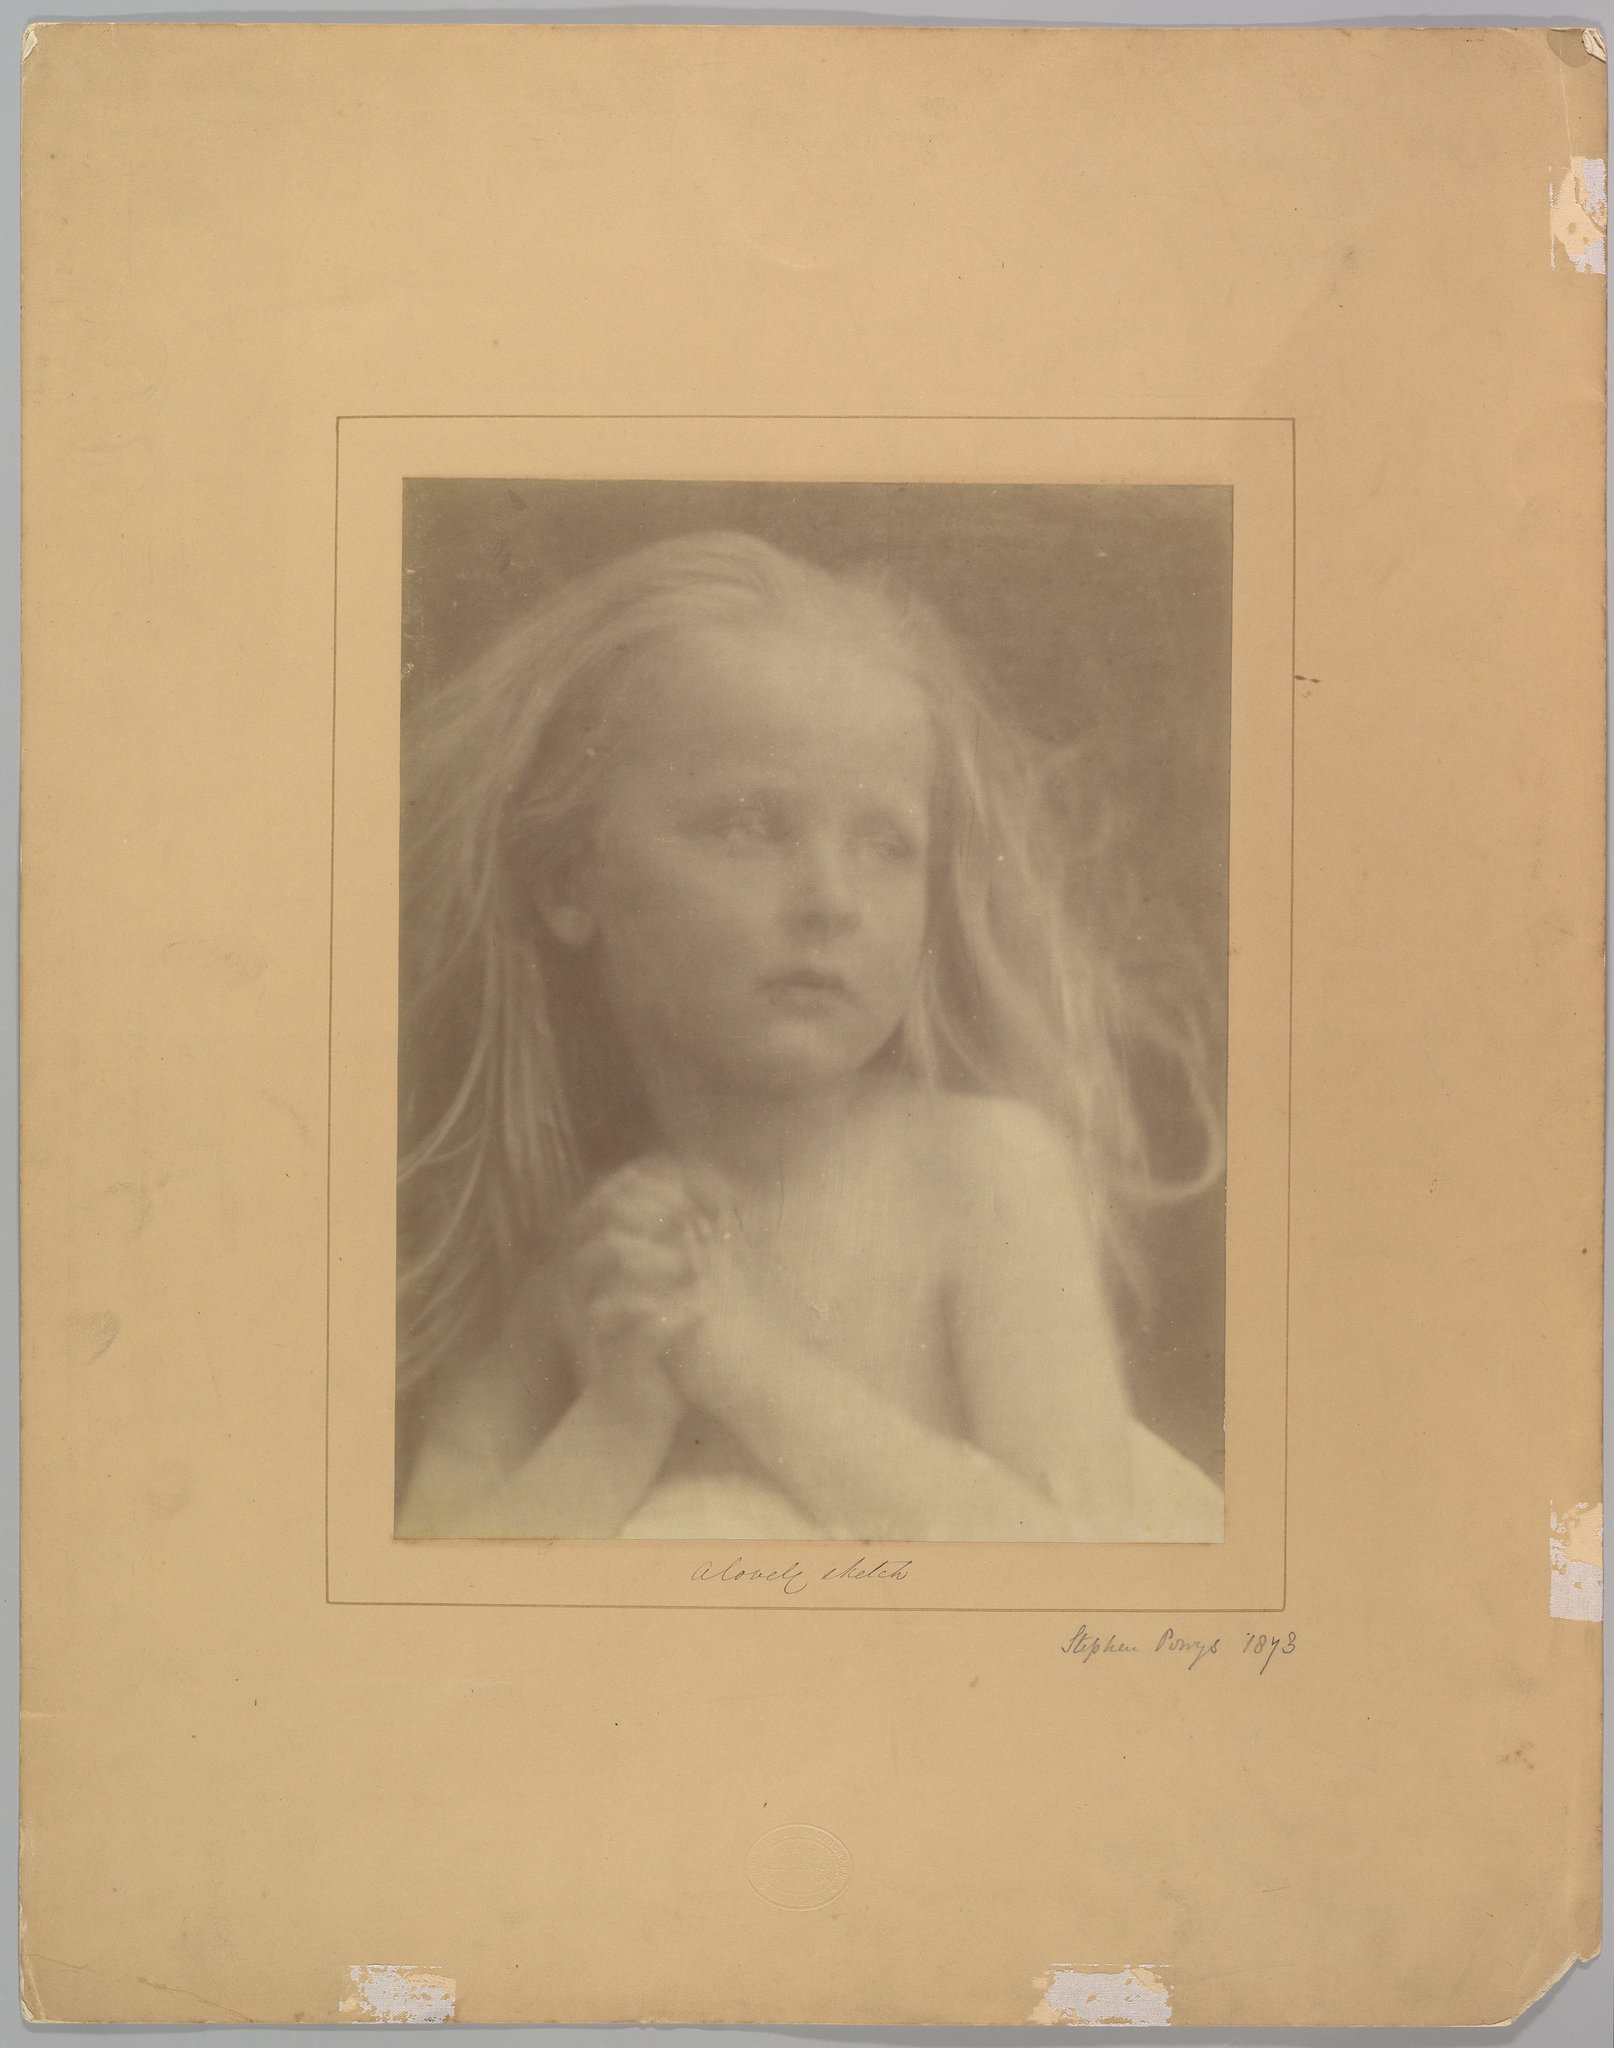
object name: photograph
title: A Lovely Sketch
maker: julia margaret cameron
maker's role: artist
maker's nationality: british, born india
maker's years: 1815-1879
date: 1873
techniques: albumen silver print, glass negative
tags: girls,portraits